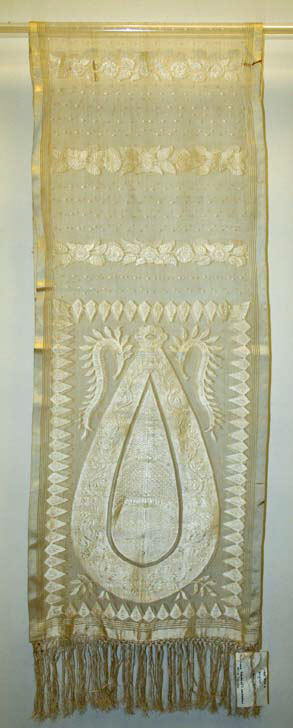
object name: scarf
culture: british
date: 1800-1810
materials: silk